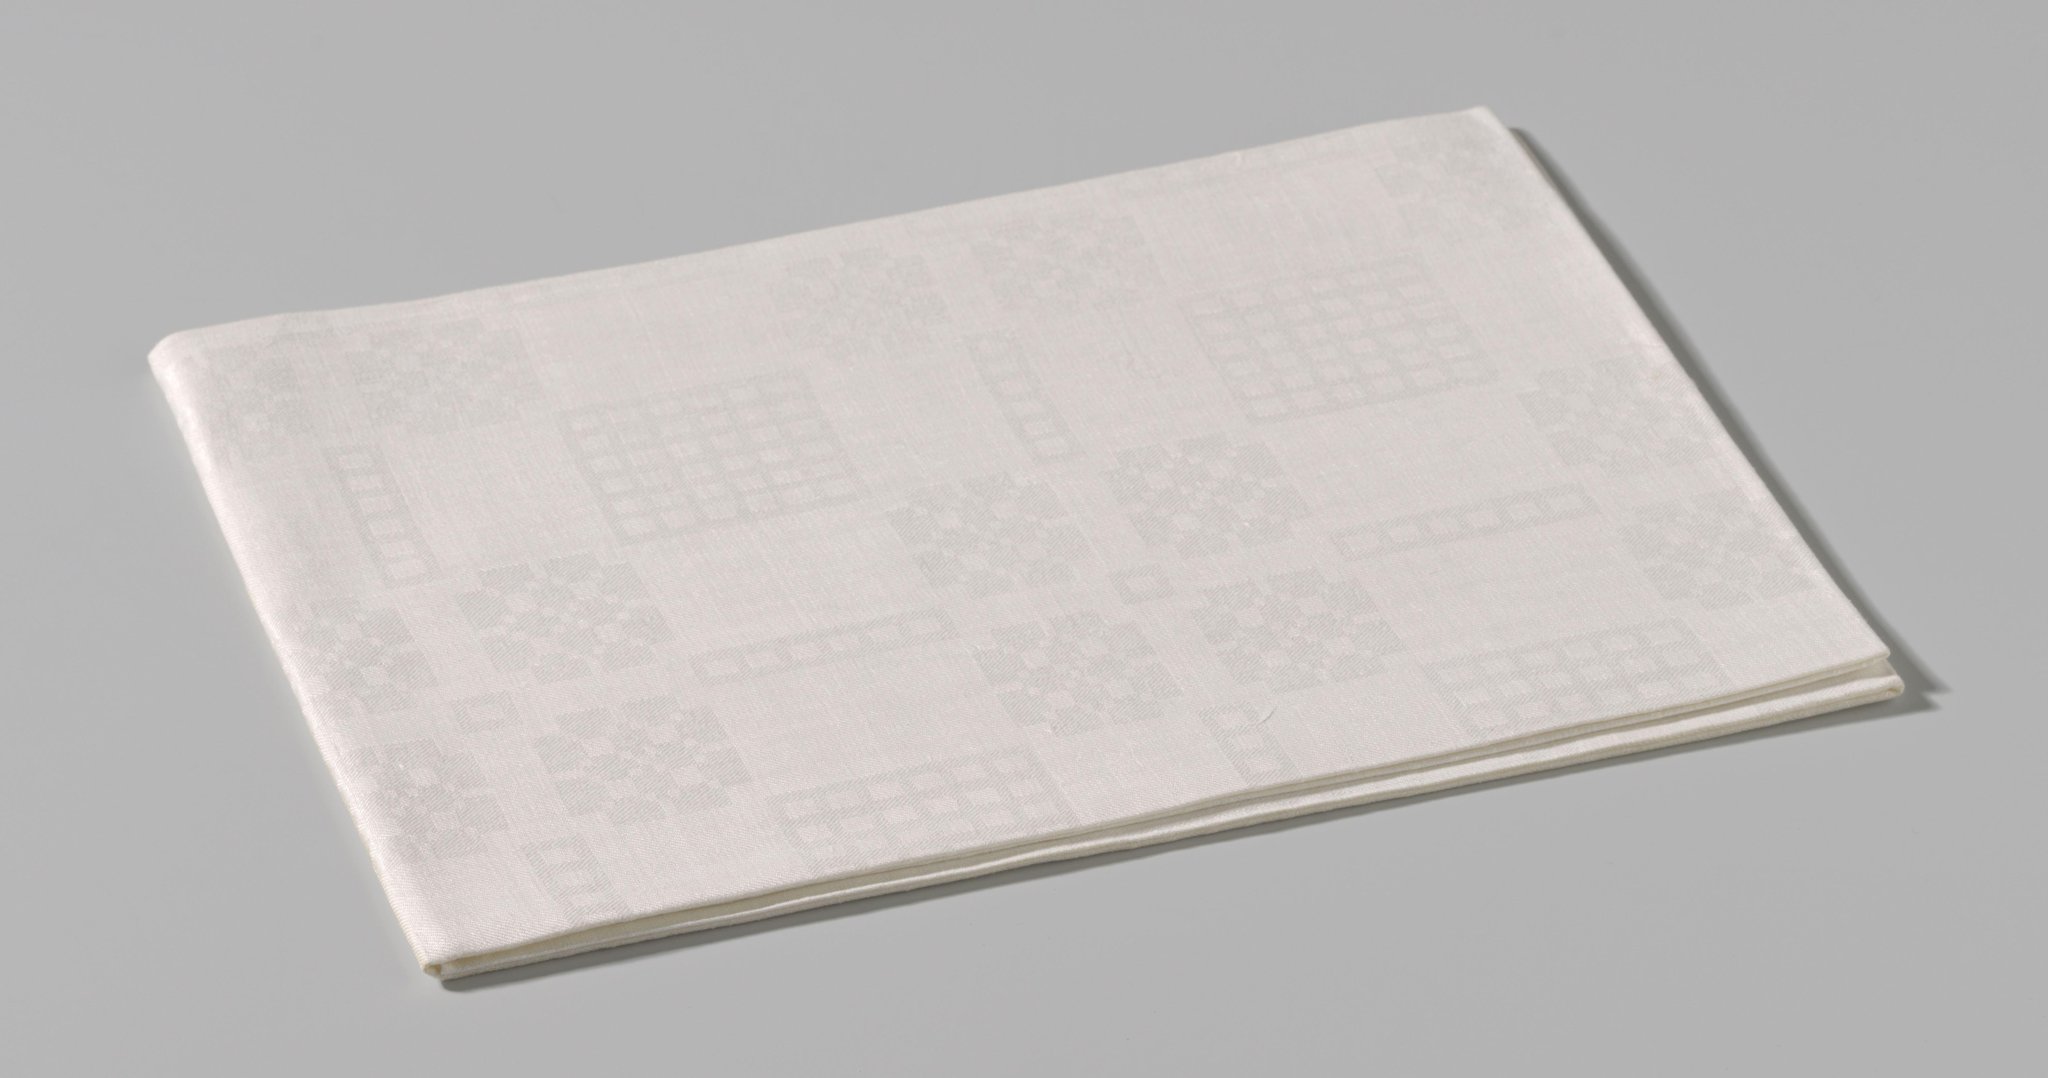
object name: napkin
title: Servet met pellenpatroon met wafelruit en bloemvorm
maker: Anonymous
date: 1675-1725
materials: linen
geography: northern netherlands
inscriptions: mark: ‘BS’, mark: ‘48’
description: Servet van wit linnen met een pellen patroon in keper, een wafelruitje met een soort bloem, merk BS en 48.